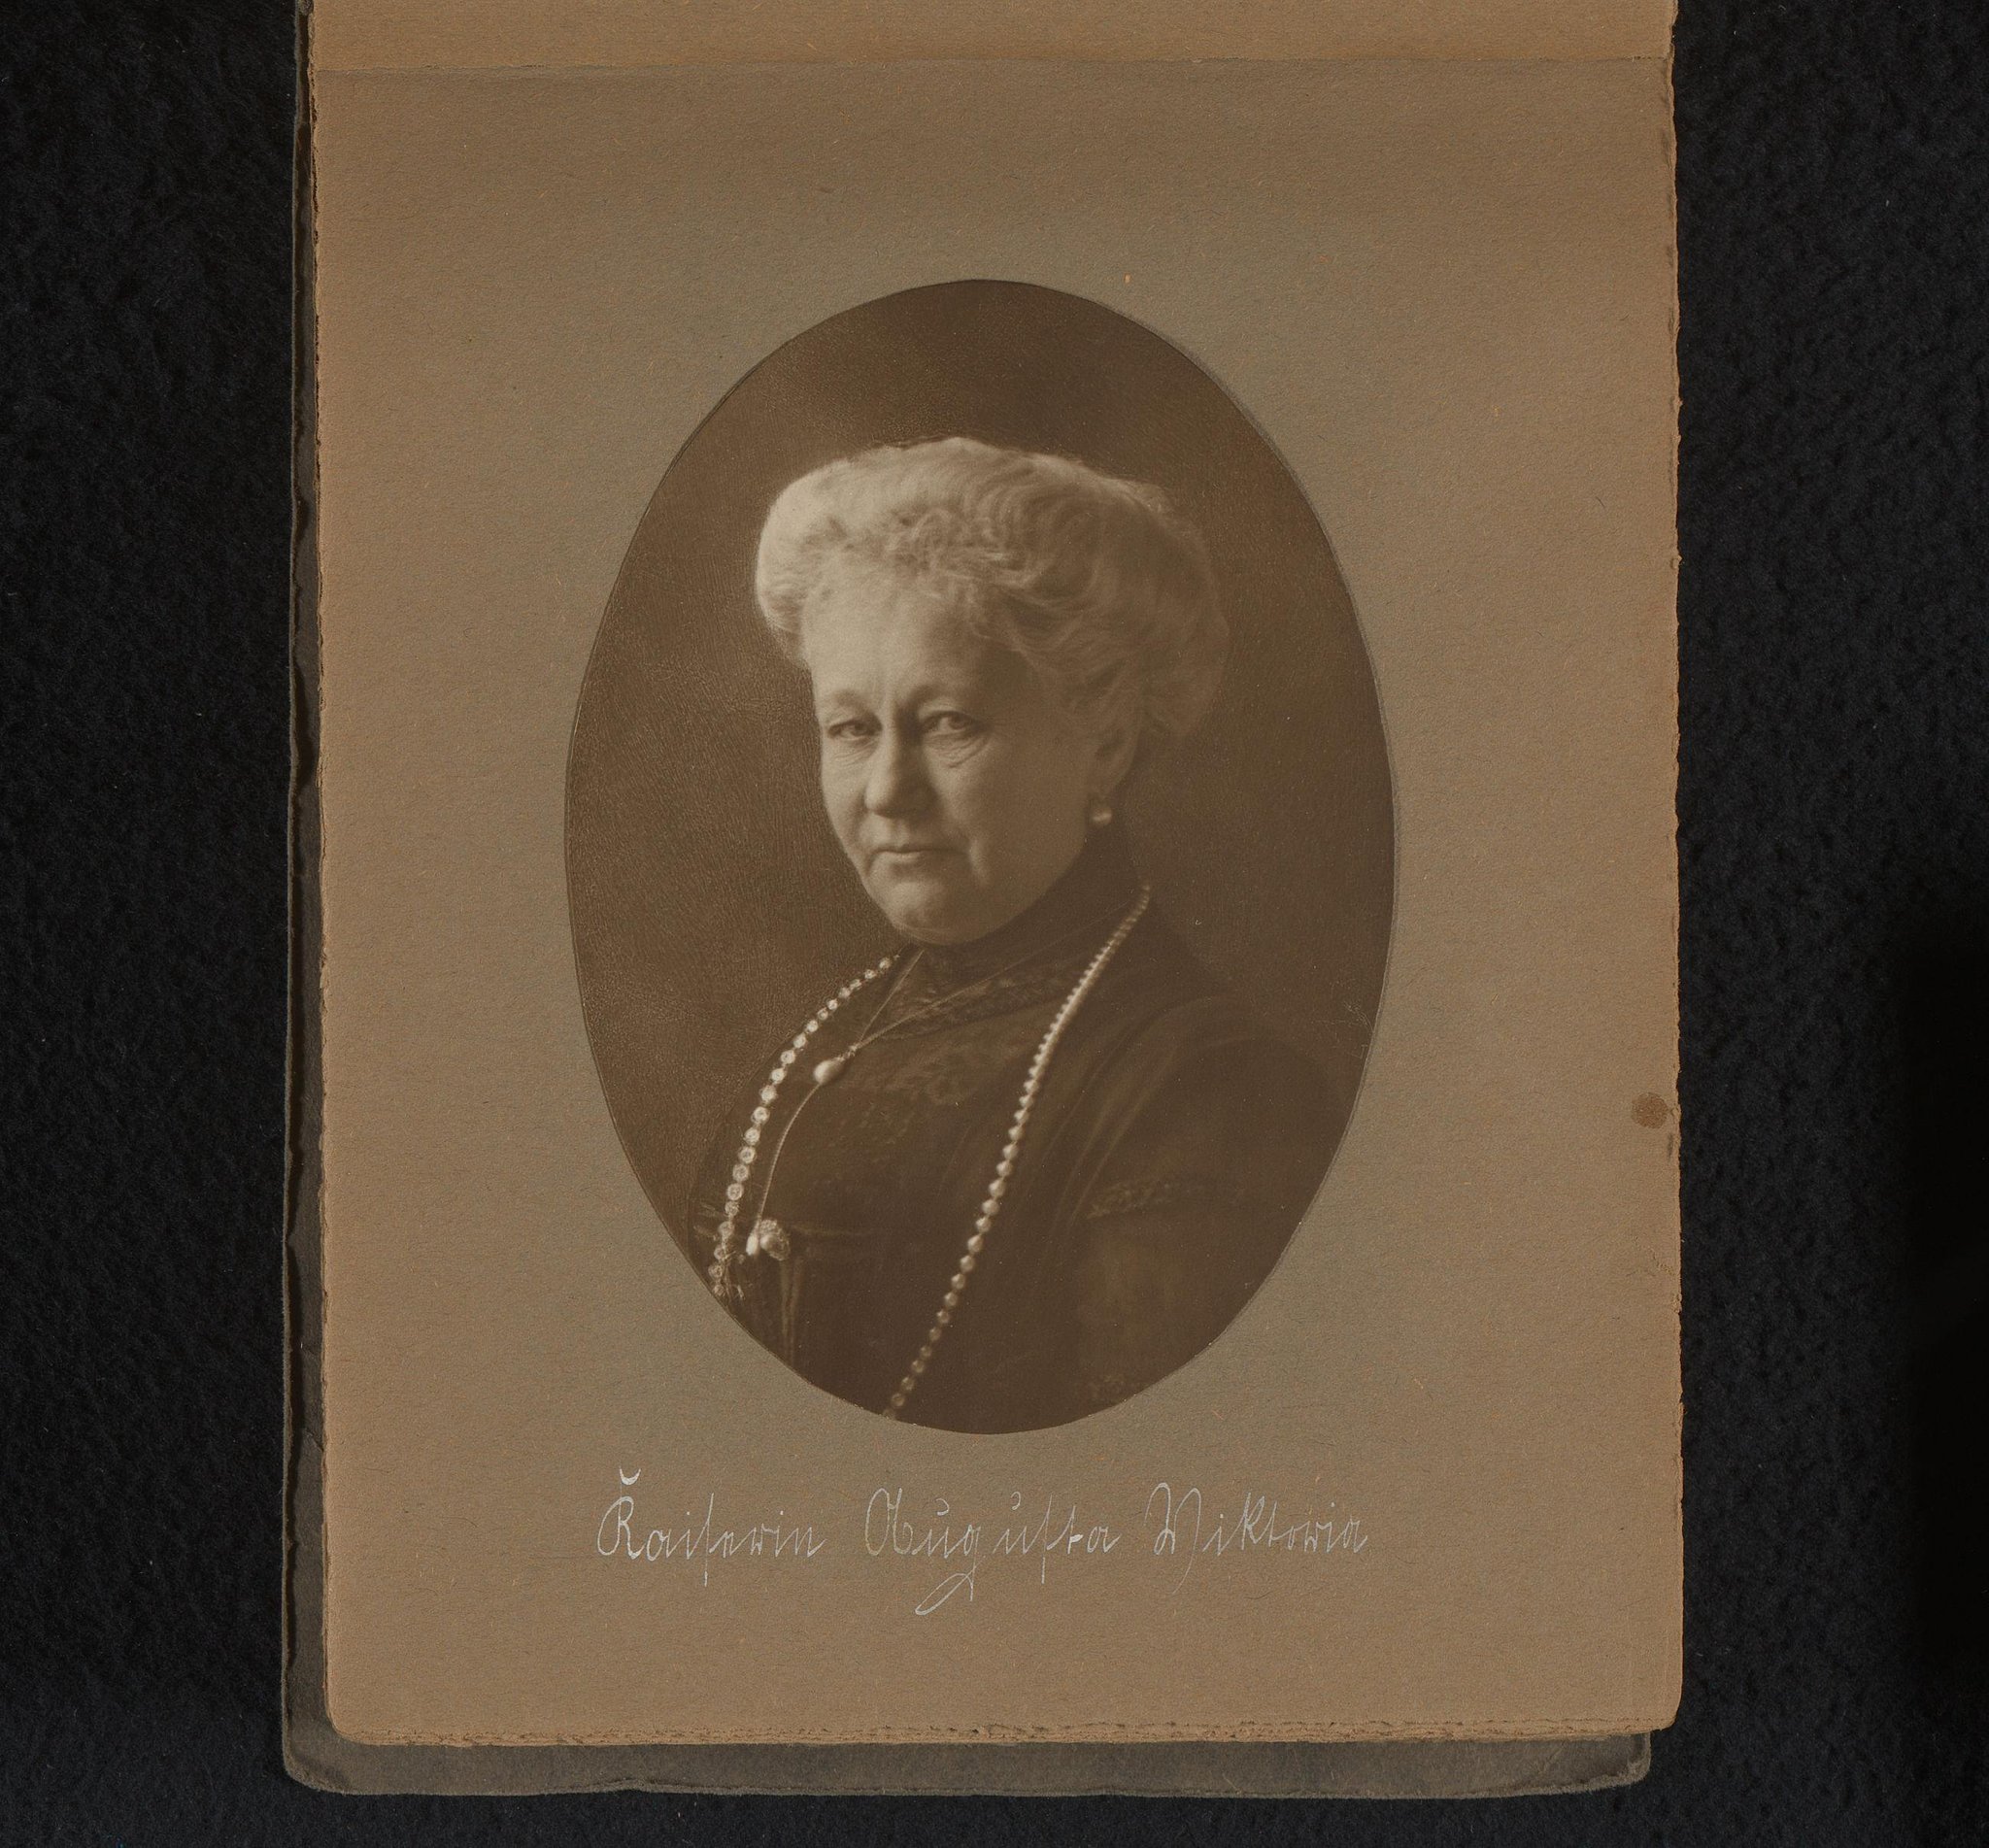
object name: album leaf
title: Portret van Augusta Victoria van Sleeswijk-Holstein-Sonderburg-Augustenburg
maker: e. sondau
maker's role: fotograaf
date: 1909-1918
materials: paper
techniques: gelatin silver print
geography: berlin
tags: augusta victoria (keizerin van duitsland), historical persons, emperor - bb - female ruler